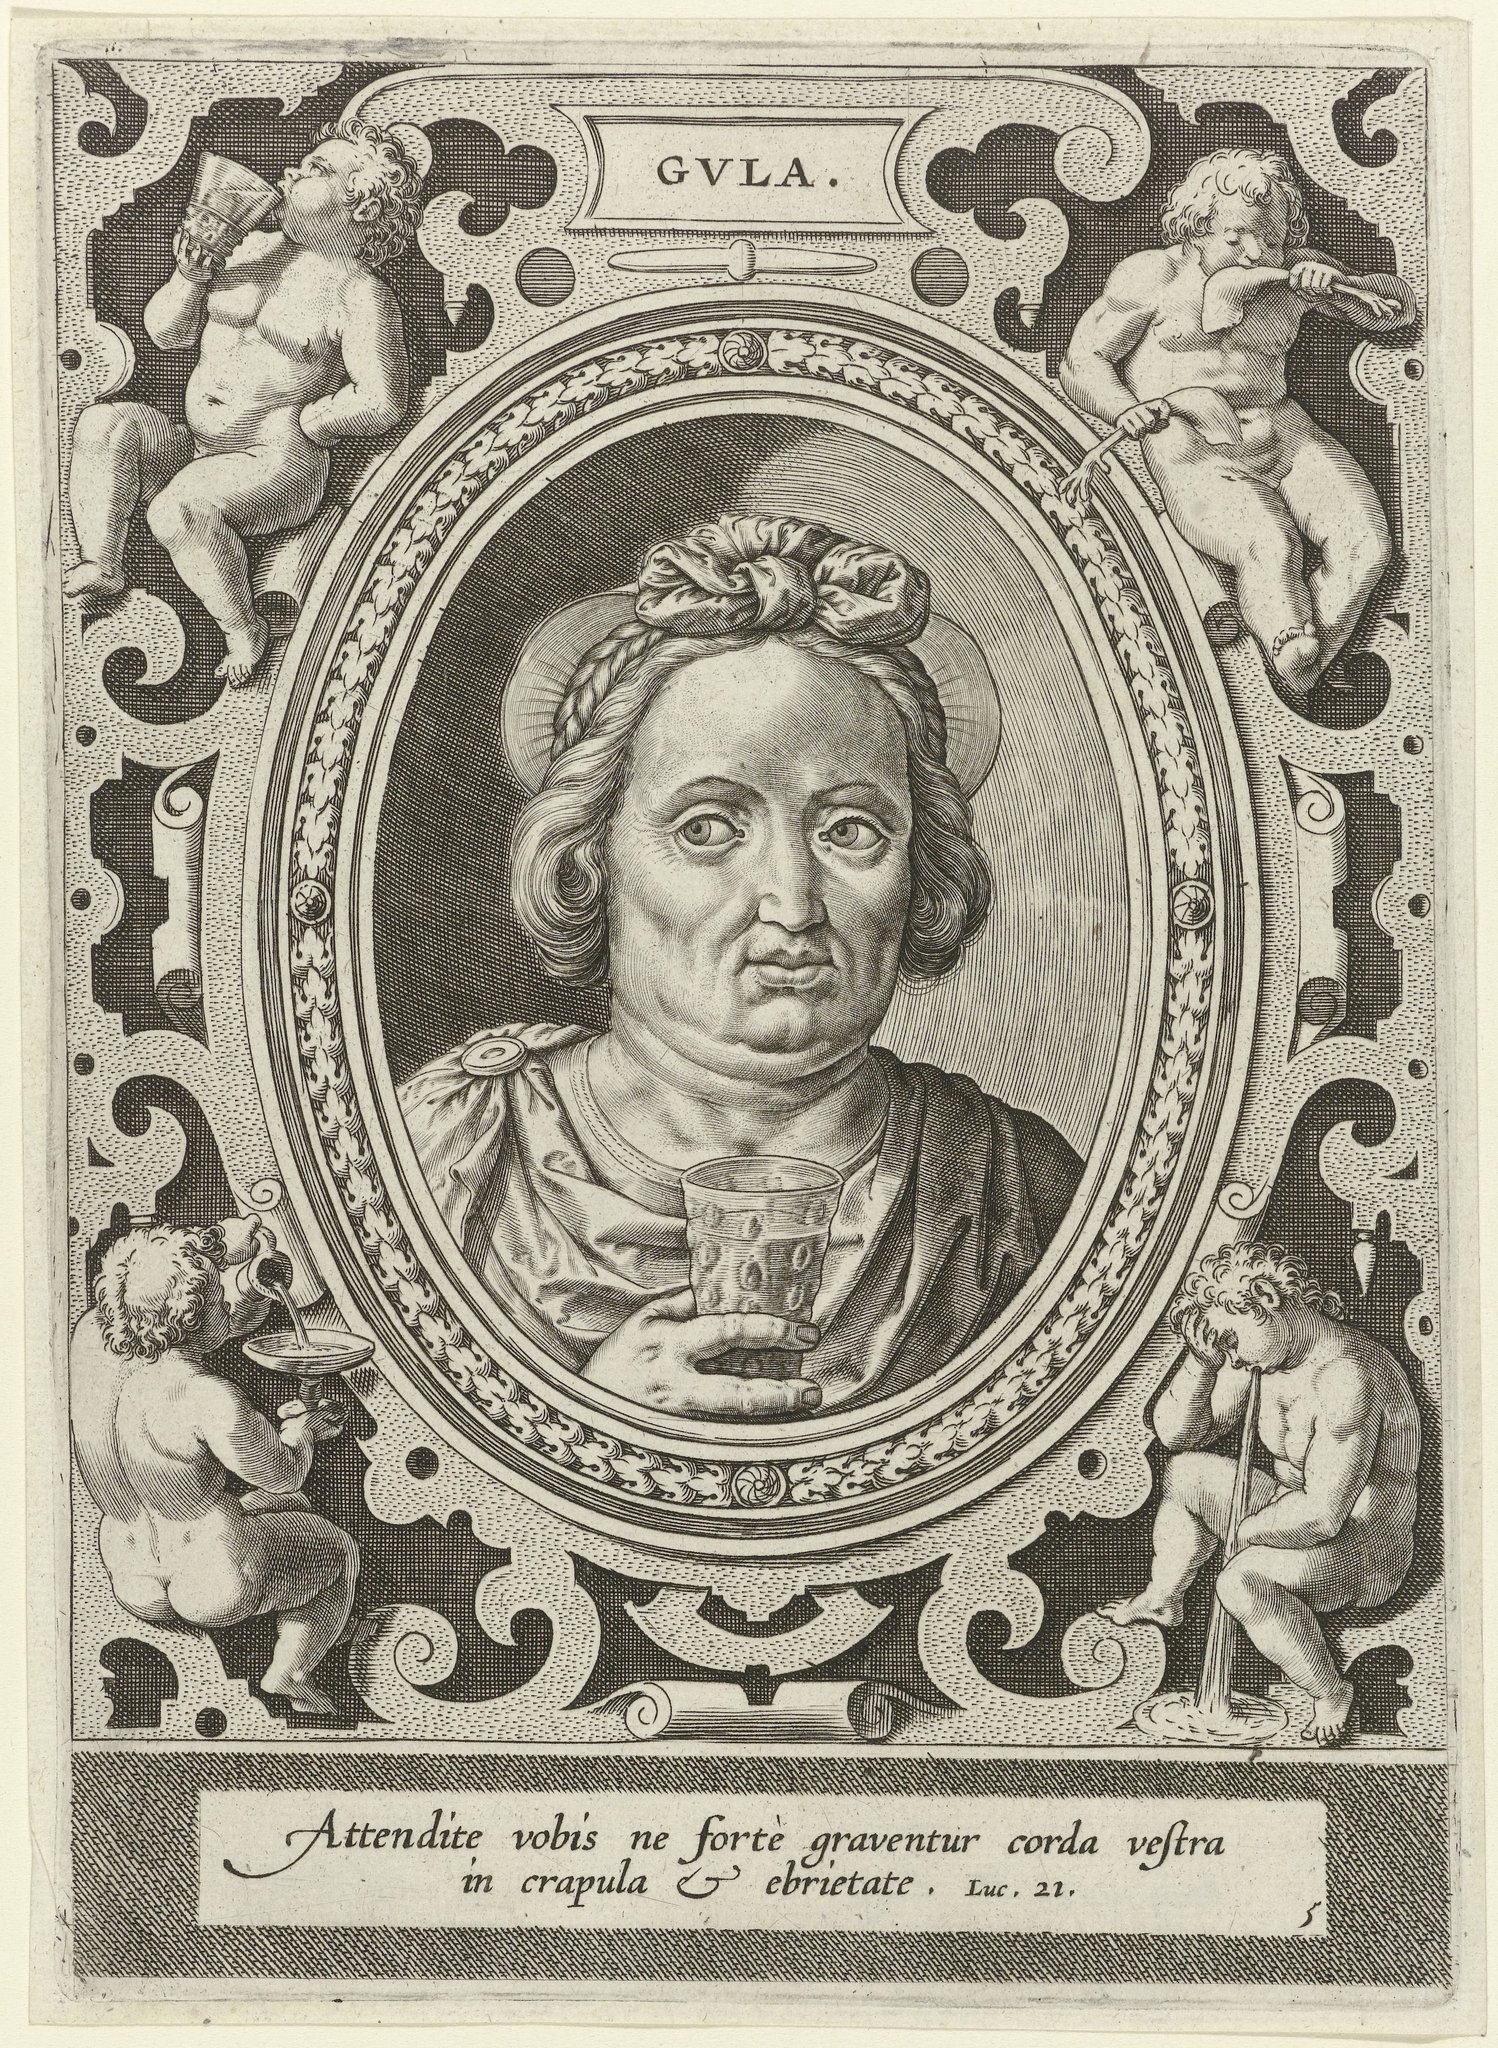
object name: print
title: VII Peccatorvm Capitalivm Imagines Elegantissime (...)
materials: paper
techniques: engraving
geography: antwerp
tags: gluttony, intemperance, 'gula'; 'gola', 'ingordigia', 'ingordigia overo avidità', 'voracità' (ripa) ~ personification of one of the seven deadly sins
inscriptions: collector's mark: Lugt 2228, collector's mark: Lugt 2542, collector's mark: Lugt 2233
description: Buste van de vrouwelijke personificatie van Gulzigheid (Gula). In haar hand een glas met drank. De voorstelling is gevat in een cartouche, omringd door putti. In het kader in de marge een Bijbelcitaat uit Luc. 21 in het Latijn.